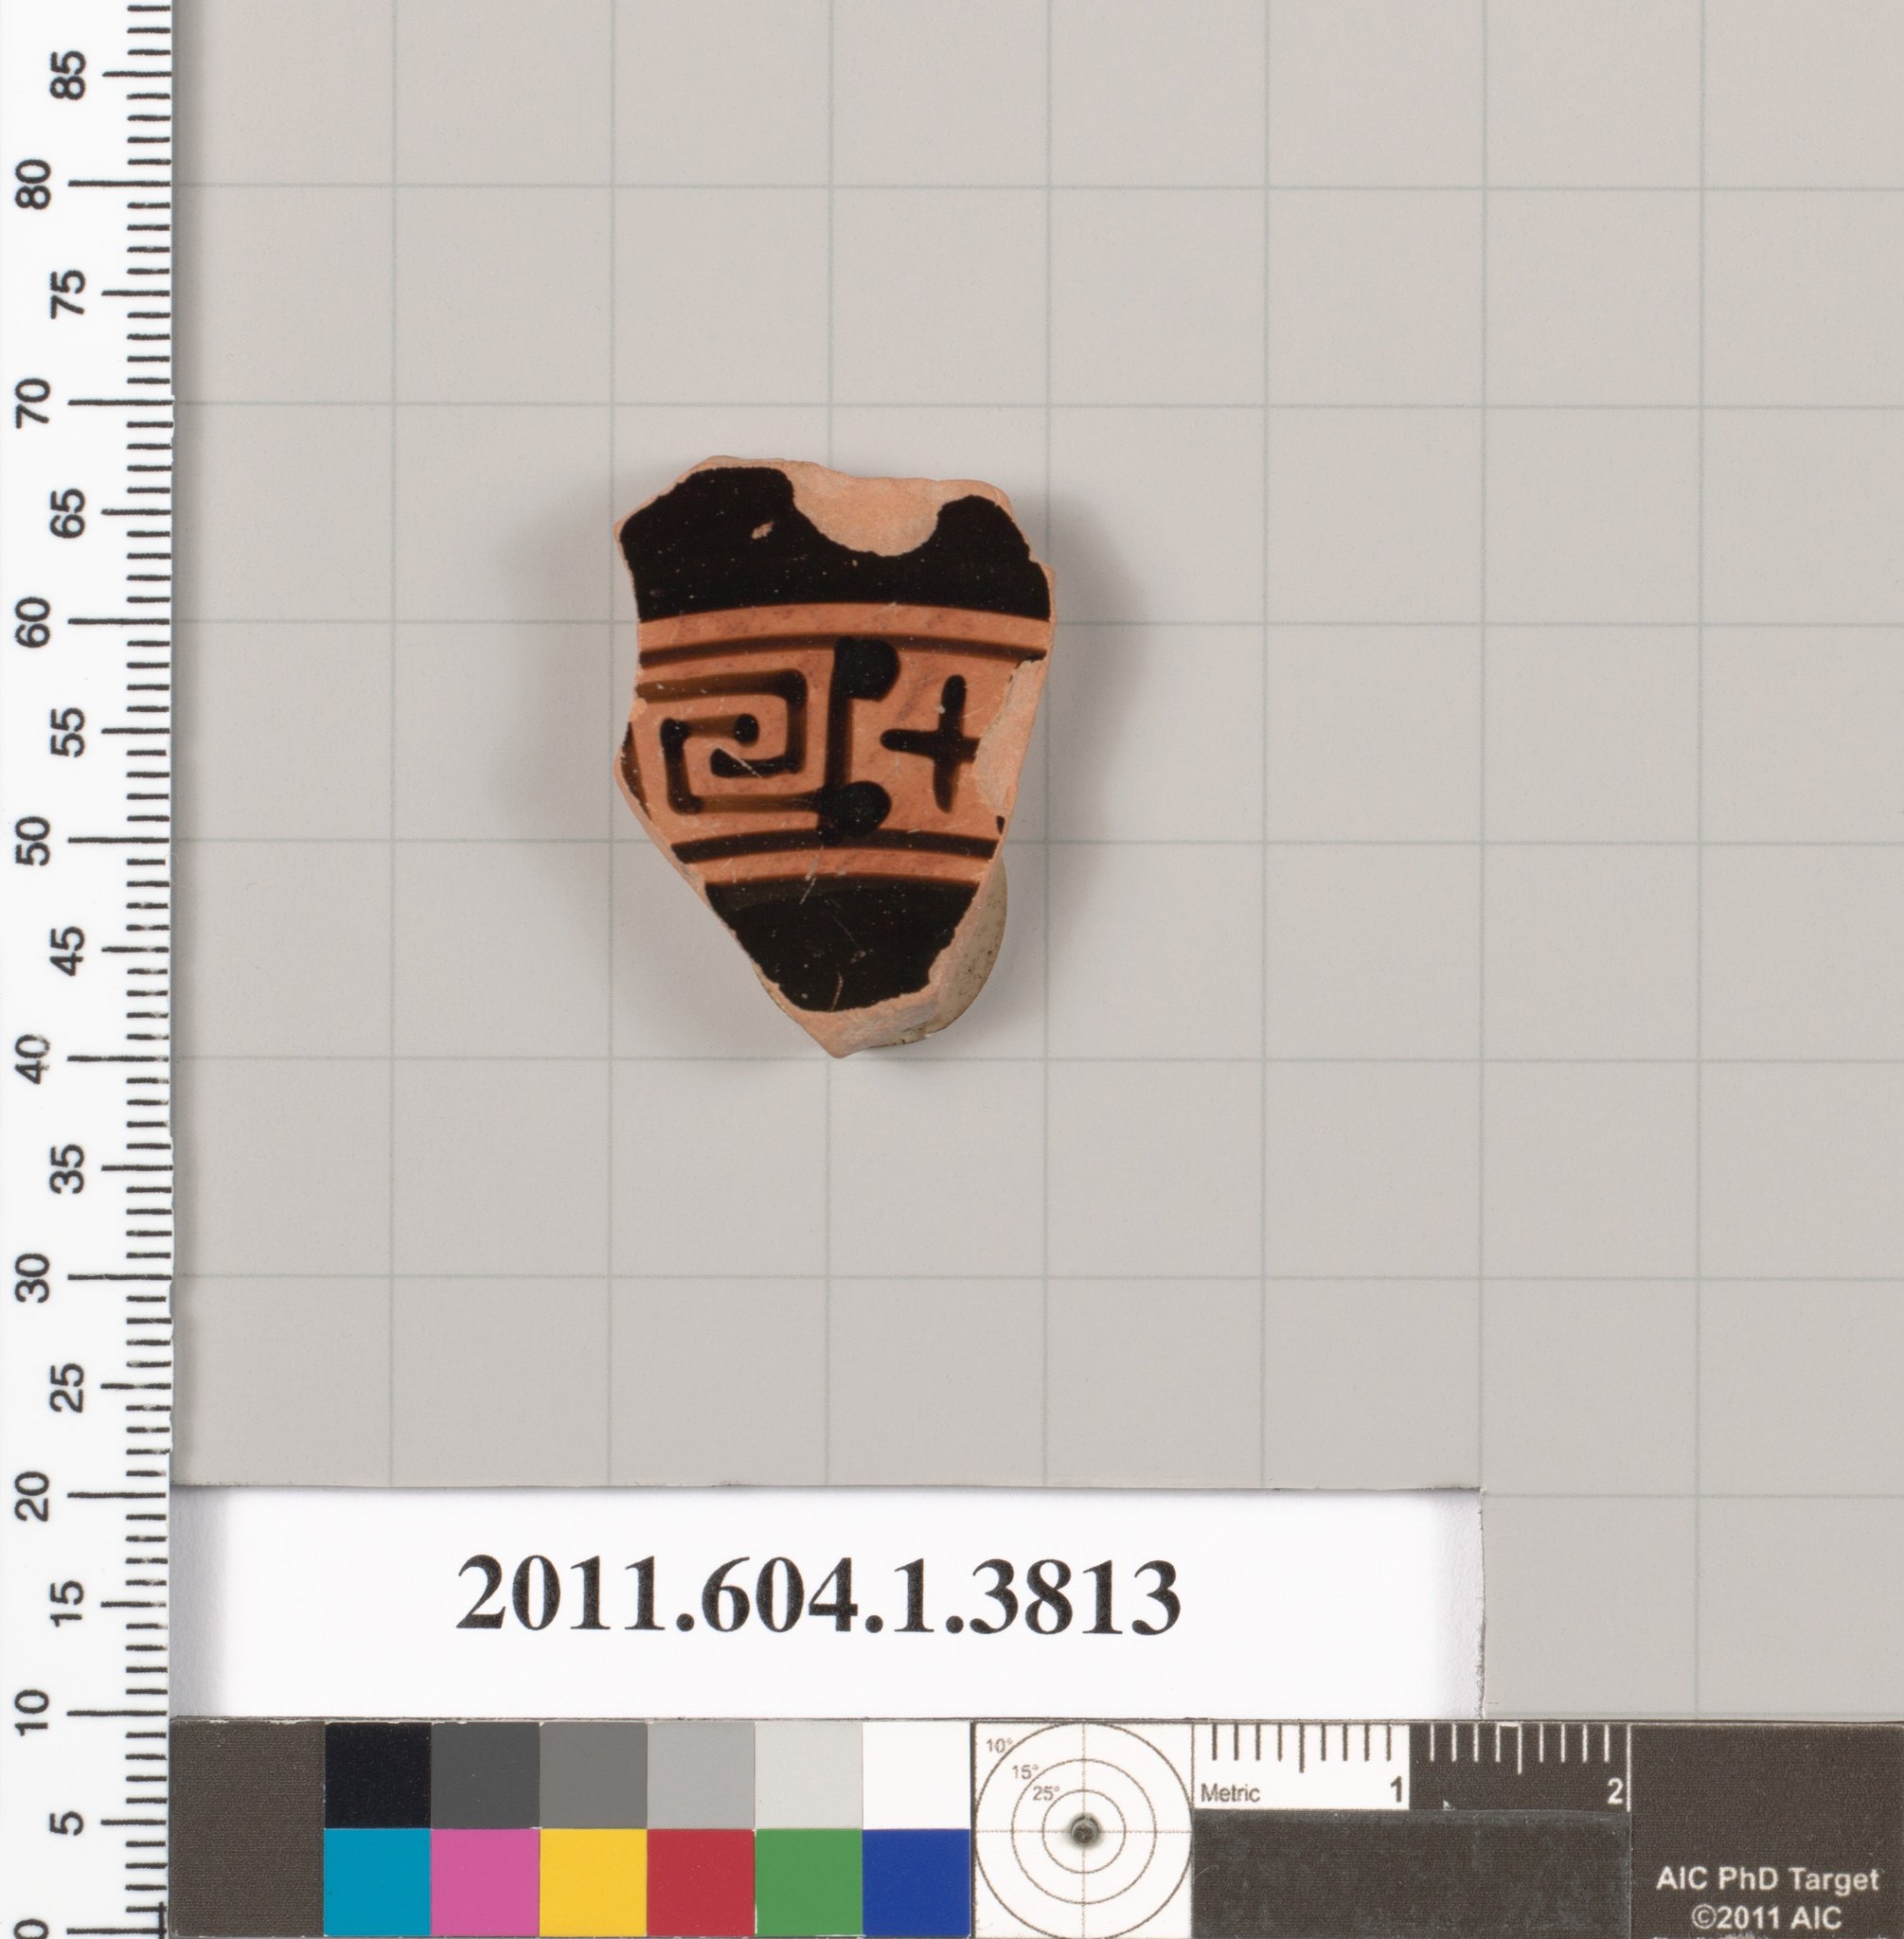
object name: kylix fragment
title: Terracotta fragment of a kylix (drinking cup)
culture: greek, attic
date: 475-451 BCE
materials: terracotta